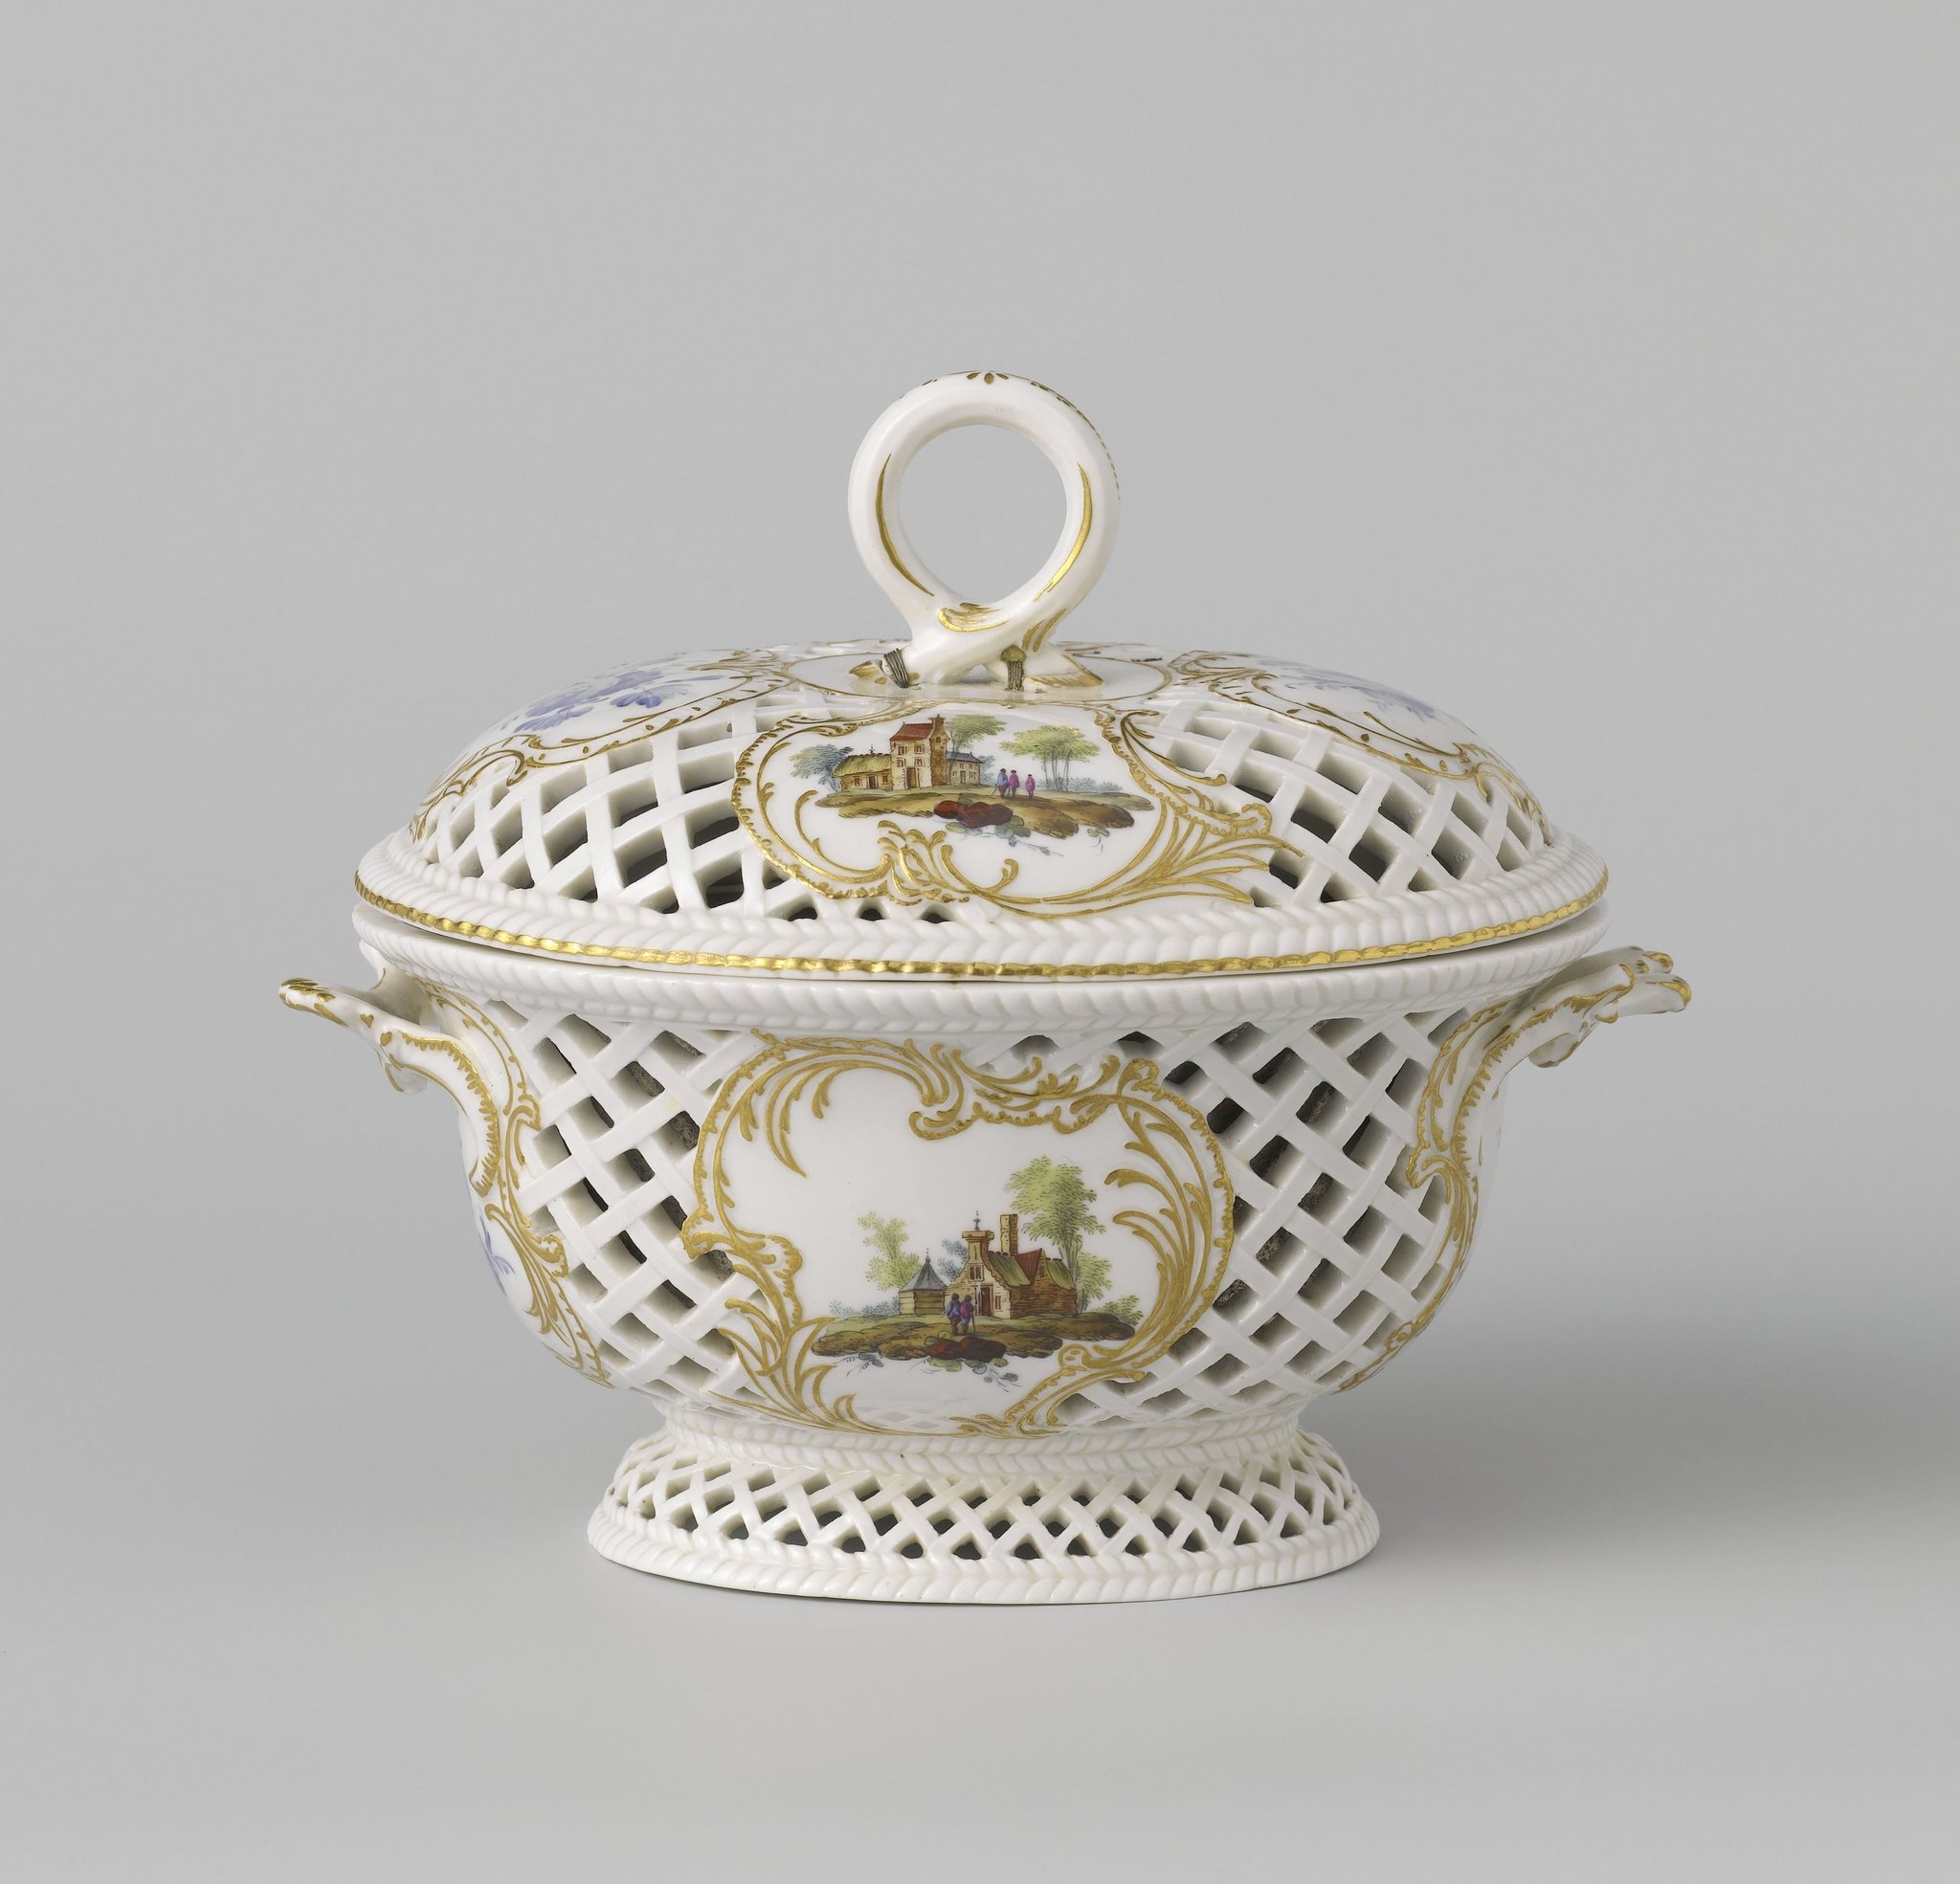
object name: kastanjevaas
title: Chestnut vase with a cityscape and bouquets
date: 1778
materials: glaze, gold, metal, paint, porcelain, soft paste porcelain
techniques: embroidery, firing, forming, gilding, turning, vitrification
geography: doornik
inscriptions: mark: ‘ooievaar’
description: Kastanjevaas van soft-paste porselein (pâte tendre) met twee kleine rocaille handvatten, beschilderd op het glazuur in emailkleuren en goud. De vaas is opengewerkt in vlechtwerk, met daarin vier vakken uitgespaard op de wand. In de vakken tweemaal een stadsgezicht en tweemaal een boeket. De deksel met dezelfde decoratie en een handvat. De vaas is voorzien van een metalen houder met deksel. Gemerkt op de onderzijde met de ooievaar.